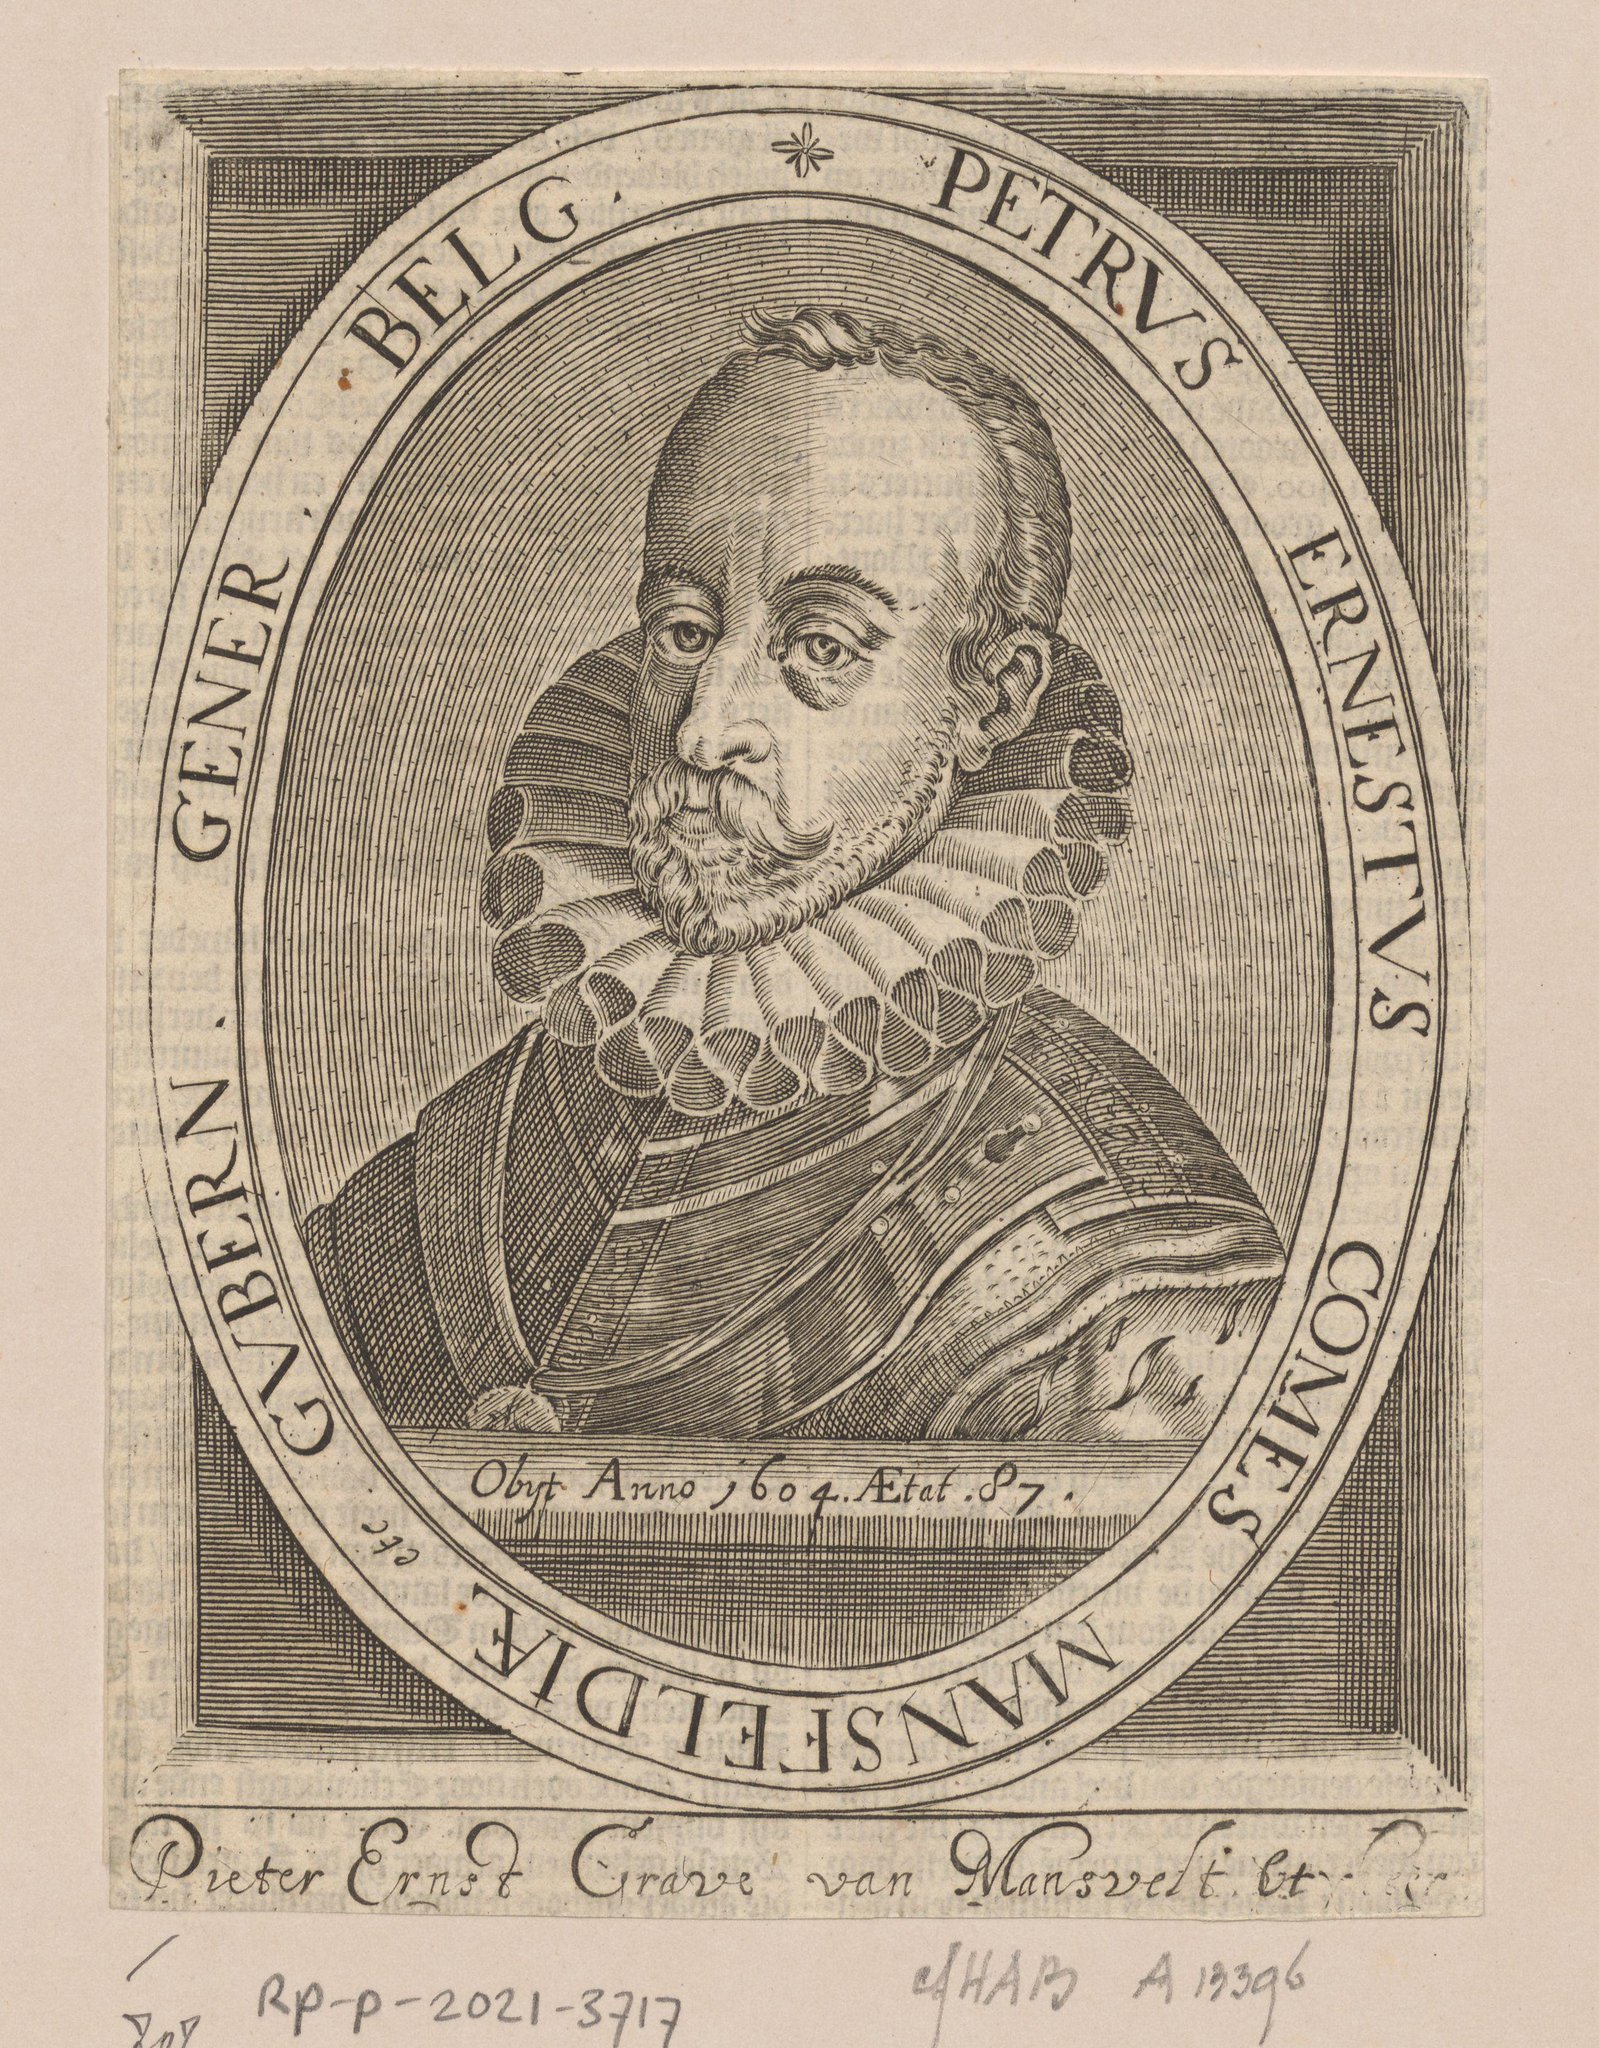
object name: book illustration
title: Portret van Peter Ernst I van Mansfeld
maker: Anonymous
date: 1652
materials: paper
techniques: engraving, letterpress printing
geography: northern netherlands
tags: ornament ~ medallion, armour, historical persons, knighthood order of the golden fleece - insignia of a knighthood order, e.g.: badge, chain (with name of order), governor, etc. of province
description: De prent is met dezelfde tekst op verso, maar in een andere druk, gebruikt in: Meteren, Emanuel van. Historien der Nederlanden, en haar naburen oorlogen (...). Amsterdam: Jan Jacobsz Schipper, 1652.